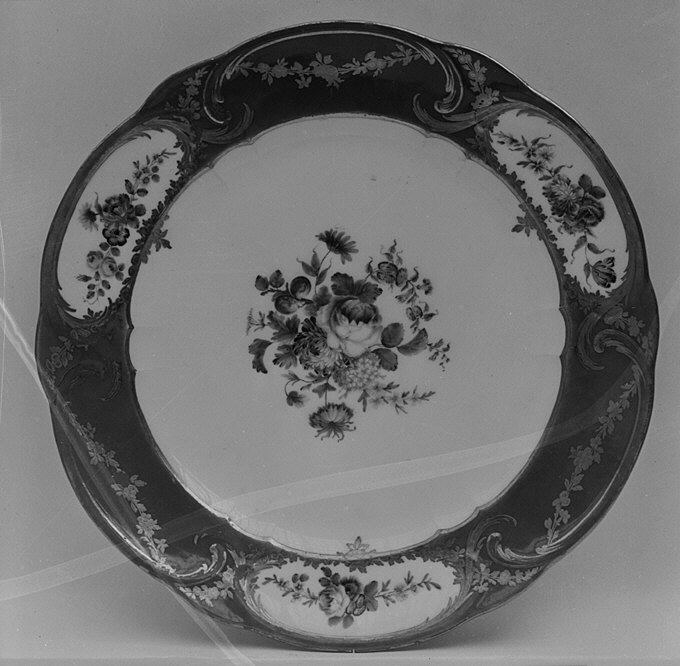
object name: plate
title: Plate (assiette à palmes) (1 of 102) (part of a service)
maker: sèvres manufactory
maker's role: manufactory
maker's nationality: french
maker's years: 1740-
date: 1775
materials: soft paste porcelain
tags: flowers